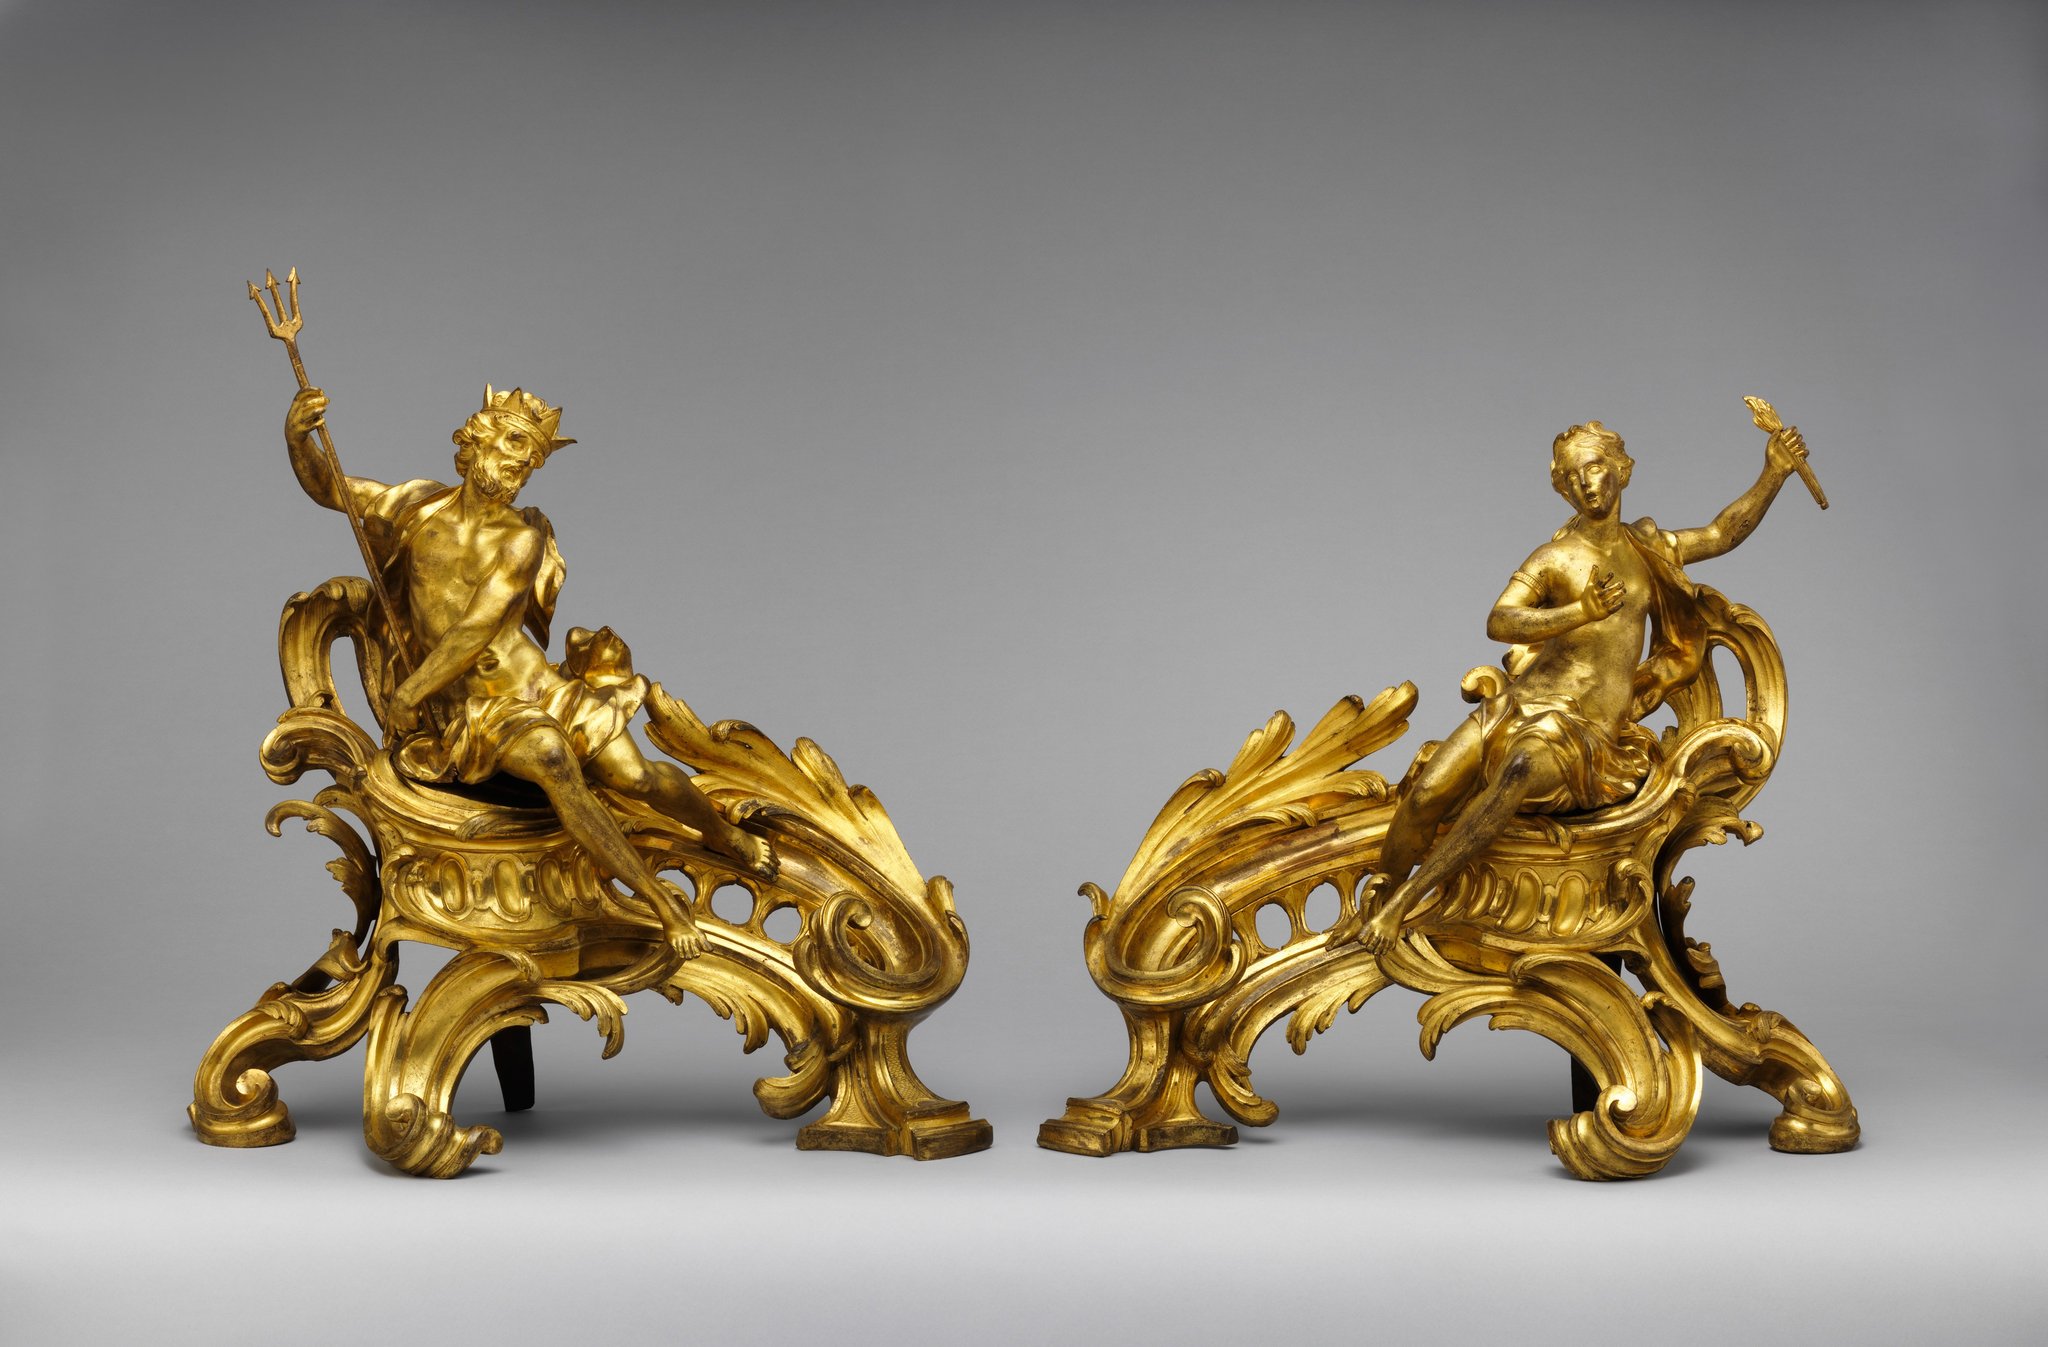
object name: firedog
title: Pair of firedogs (chenets)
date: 1750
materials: gilt bronze